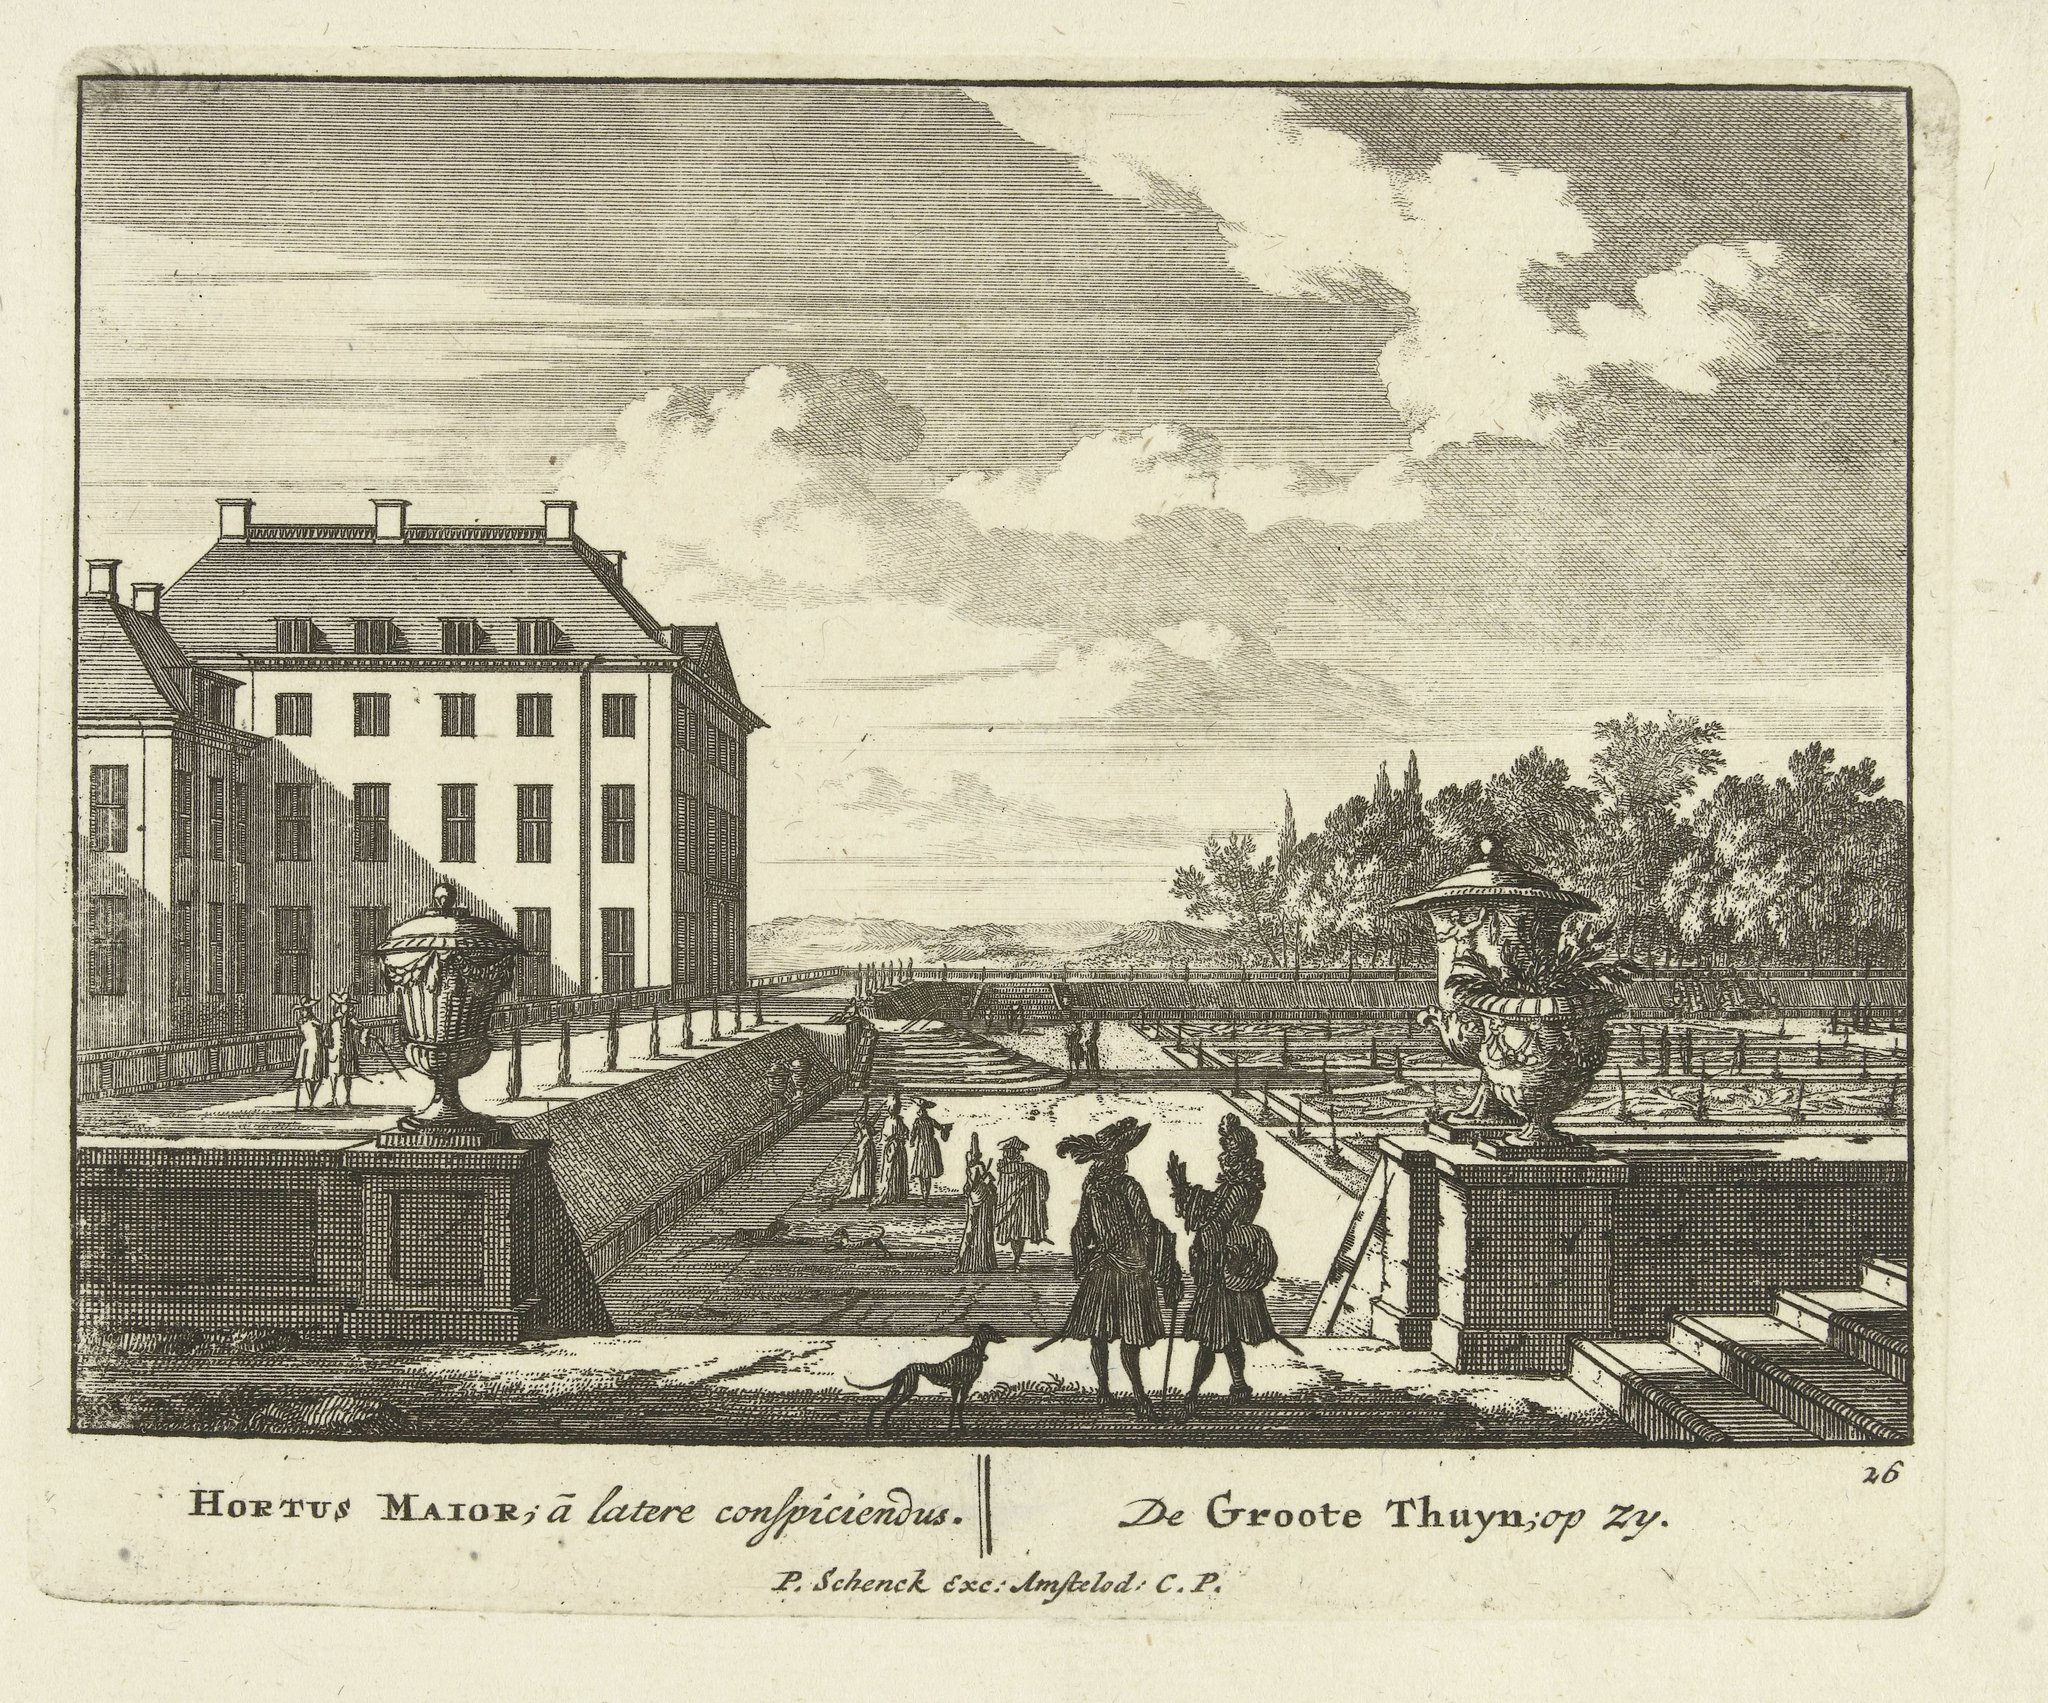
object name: print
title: Uitgeleesene Gesichte van het Wijdvermaarde Loo als andere vorstelijke Huisen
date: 1695-1705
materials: paper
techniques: etching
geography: amsterdam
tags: palace, french or architectonic garden; formal garden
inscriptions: collector's mark: Lugt 2228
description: Prent uit een serie van 71 prenten met Rijnlandschappen, gezichten op vorstelijke paleizen en stadsgezichten uit Den Haag en Amsterdam.